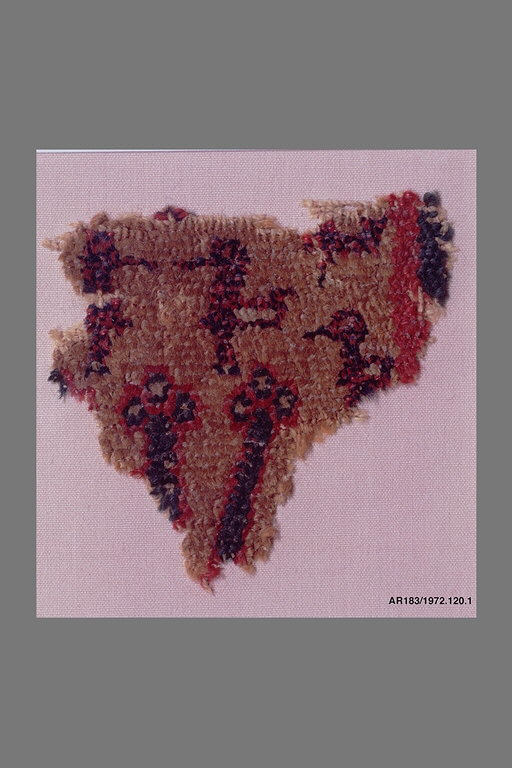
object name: carpet fragment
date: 1301-1400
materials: wool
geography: spain